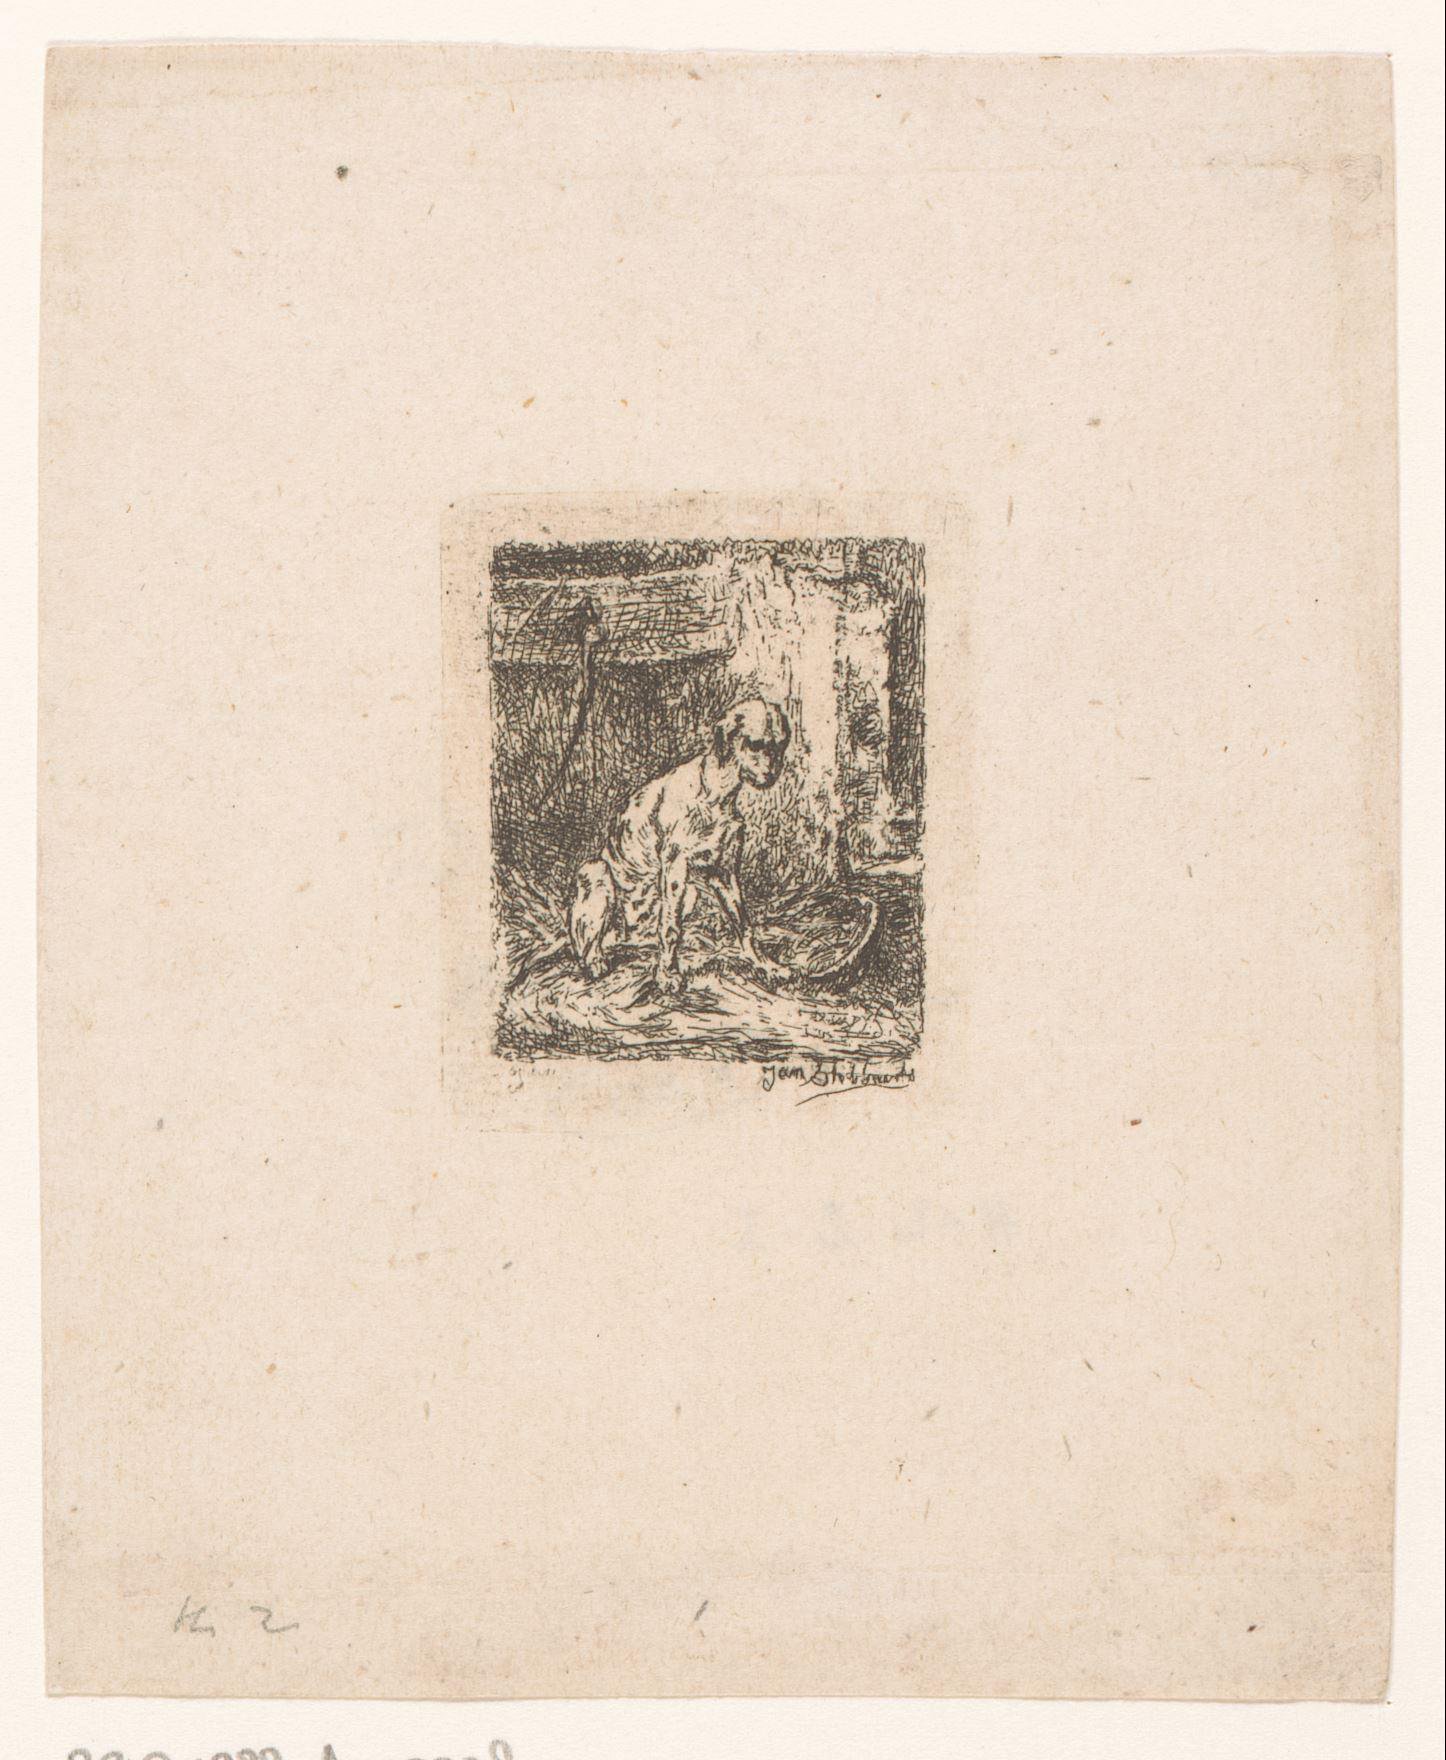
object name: print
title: Hond in een hok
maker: jan stobbaerts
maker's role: draughtsman, print maker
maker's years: 1838-1914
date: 1848-1879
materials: paper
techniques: etching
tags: dog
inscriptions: collector's mark: Lugt 2228